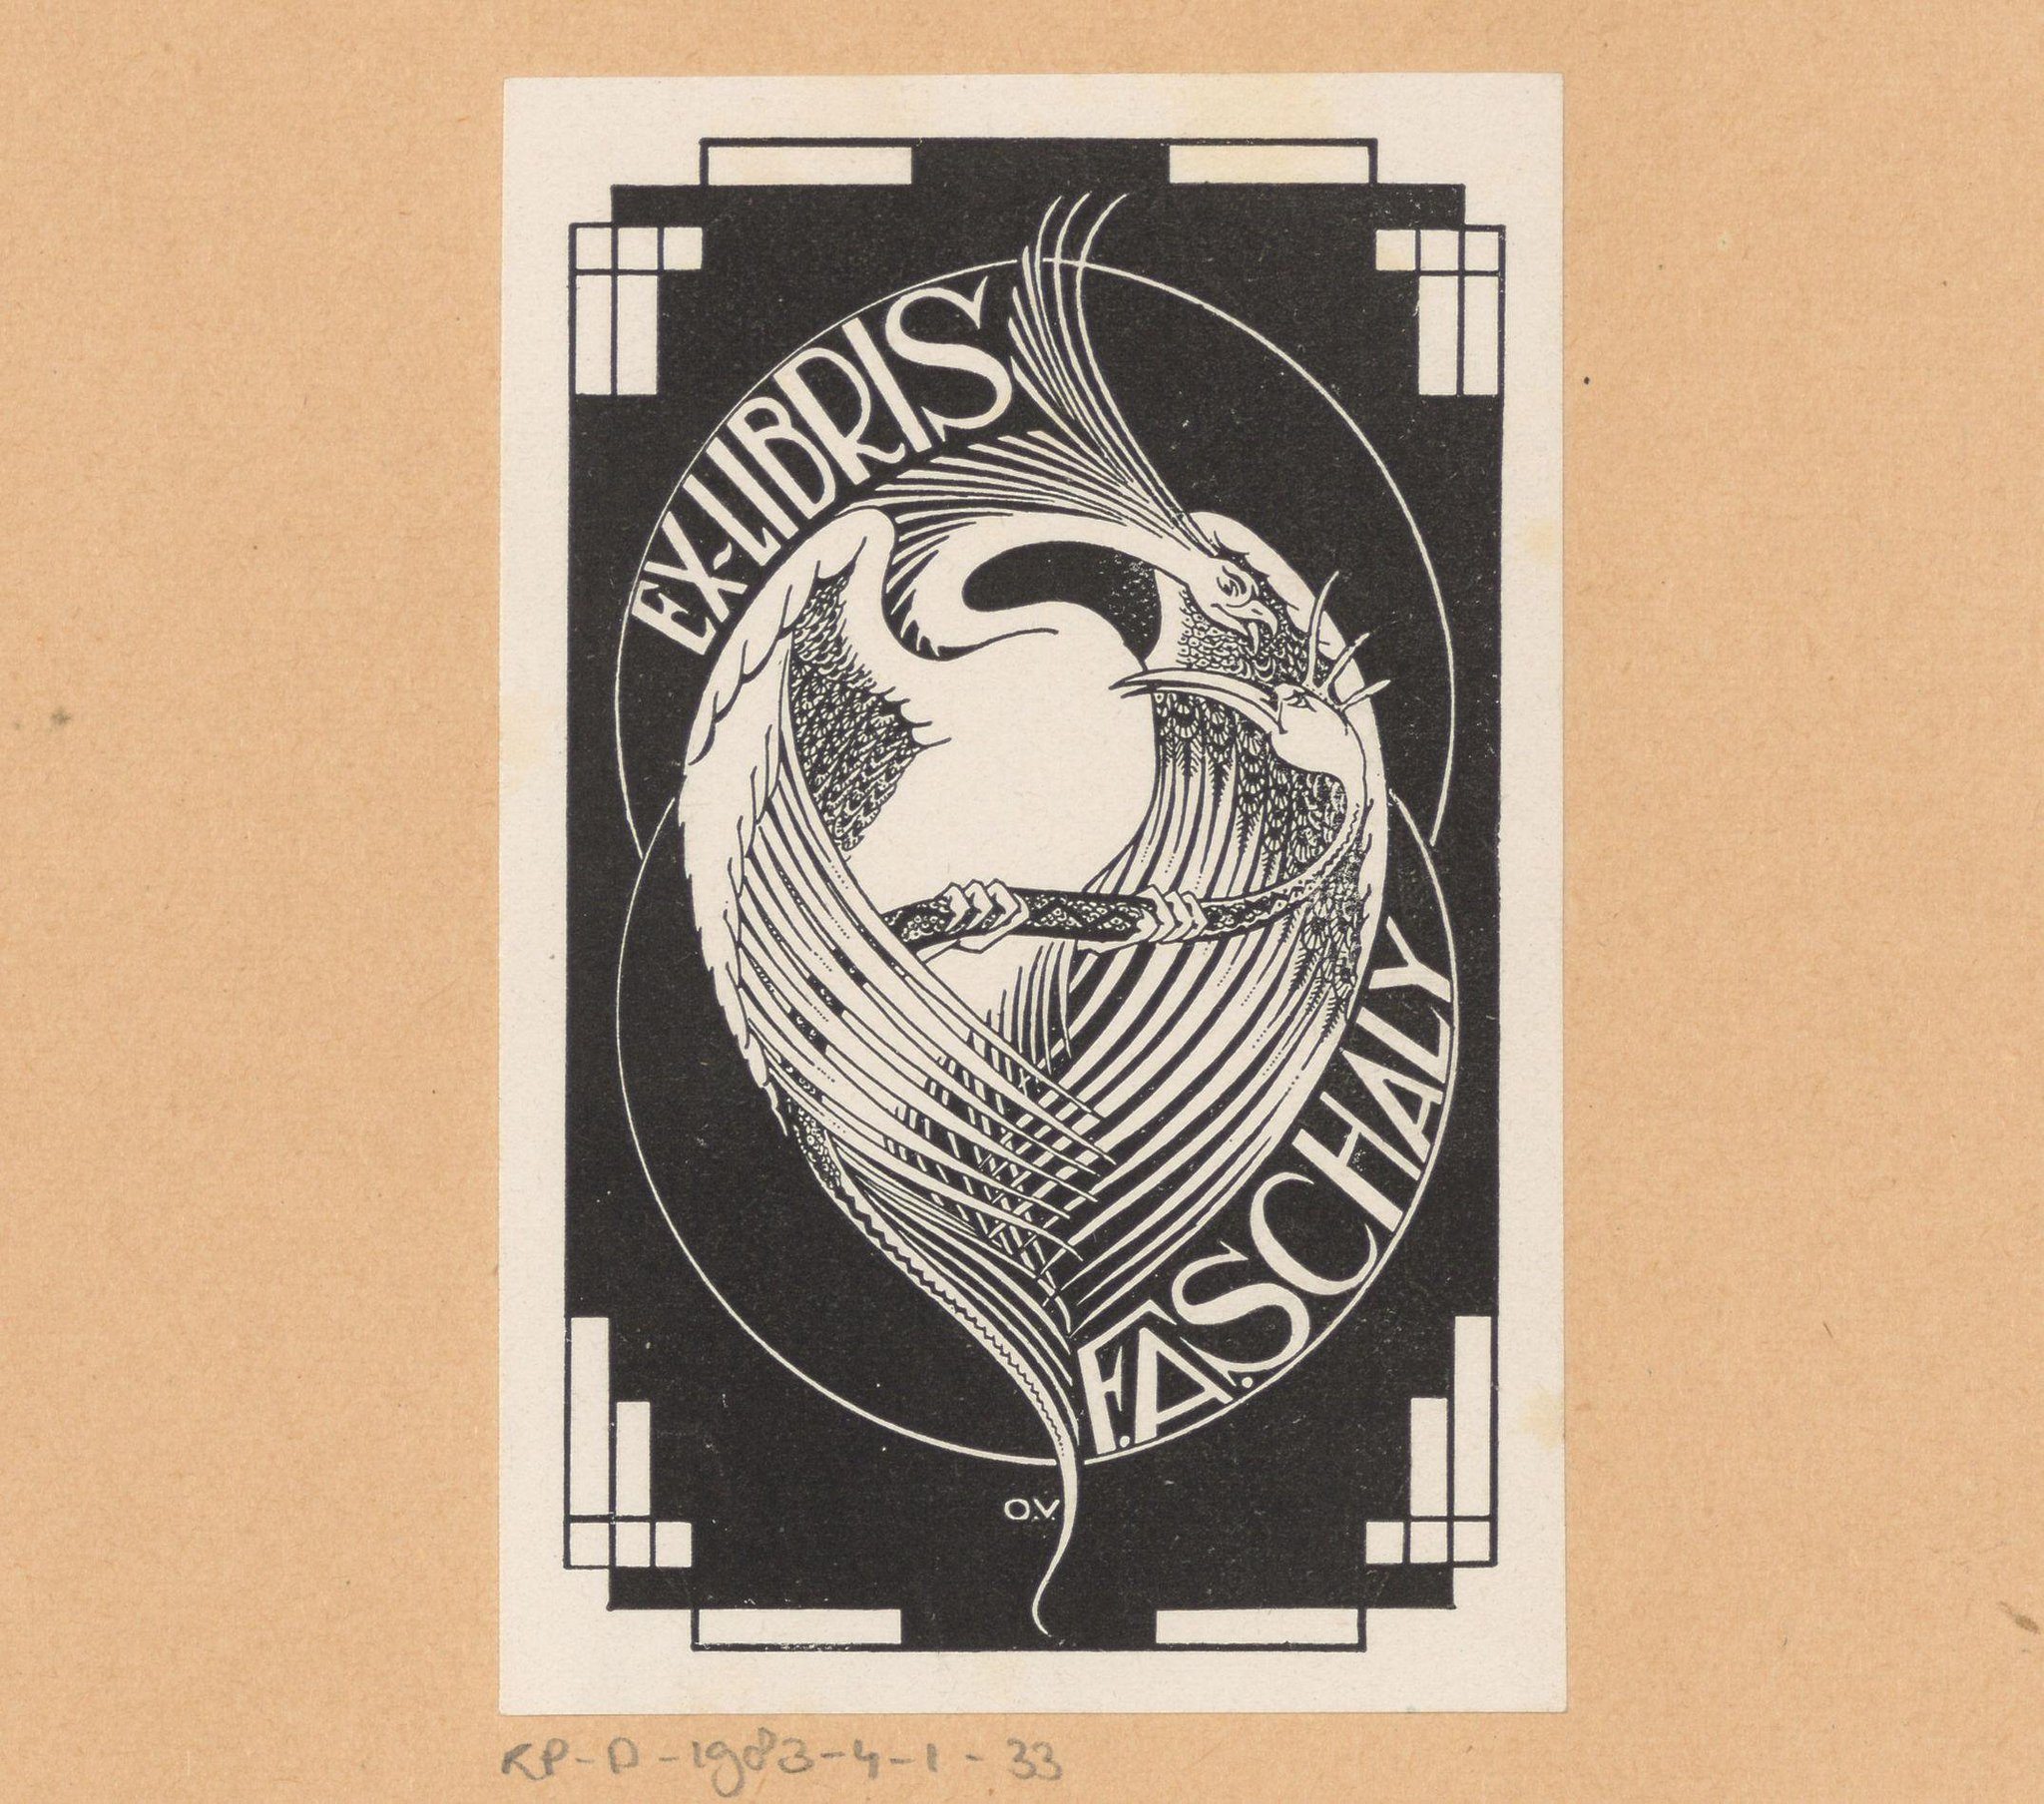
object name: bookplate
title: Ex libris van F.A. Schaly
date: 1929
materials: paper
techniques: printing block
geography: netherlands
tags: snakes, birds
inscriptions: inscription: ‘Clichédruk - Jaar 1929 (...) uitg. Stols 1950.’, inscription: ‘Basilisk was in (...) slang. "Ankh" levensteken.’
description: Het ex libris wordt vergezeld door een tekstblad waarop de voorstelling vaan de verschillende ontwerpen voor deze prent worden geduid. De basilisk of de slag verbeeldt de ziekte, die wordt aangevallen door de secretarisvogel. De vogel staat hier voor de geneeskunde. In een andere voorstelling vecht de basilisk, "de koning der slangen" met een wezel. Volgens Verhagen had de basilisk in oud-hollandse opvatting een slang met een paddenlijd en een gekroonde hanenkop. Ex libris is opgenomen in "De Gulden Winckel", april 1930, het "Nederlandsch Tijdschrift voor Geneeskunde", 1941 en in "Het ex libris der Nederlansche Medici", M.C. Croockewit, 1950. Ontwerp werd door Verhagen ingezonden voor de 6th Annual ex libris exhibition van The Bookplate Association International, mei 1930 in Los Angeles.